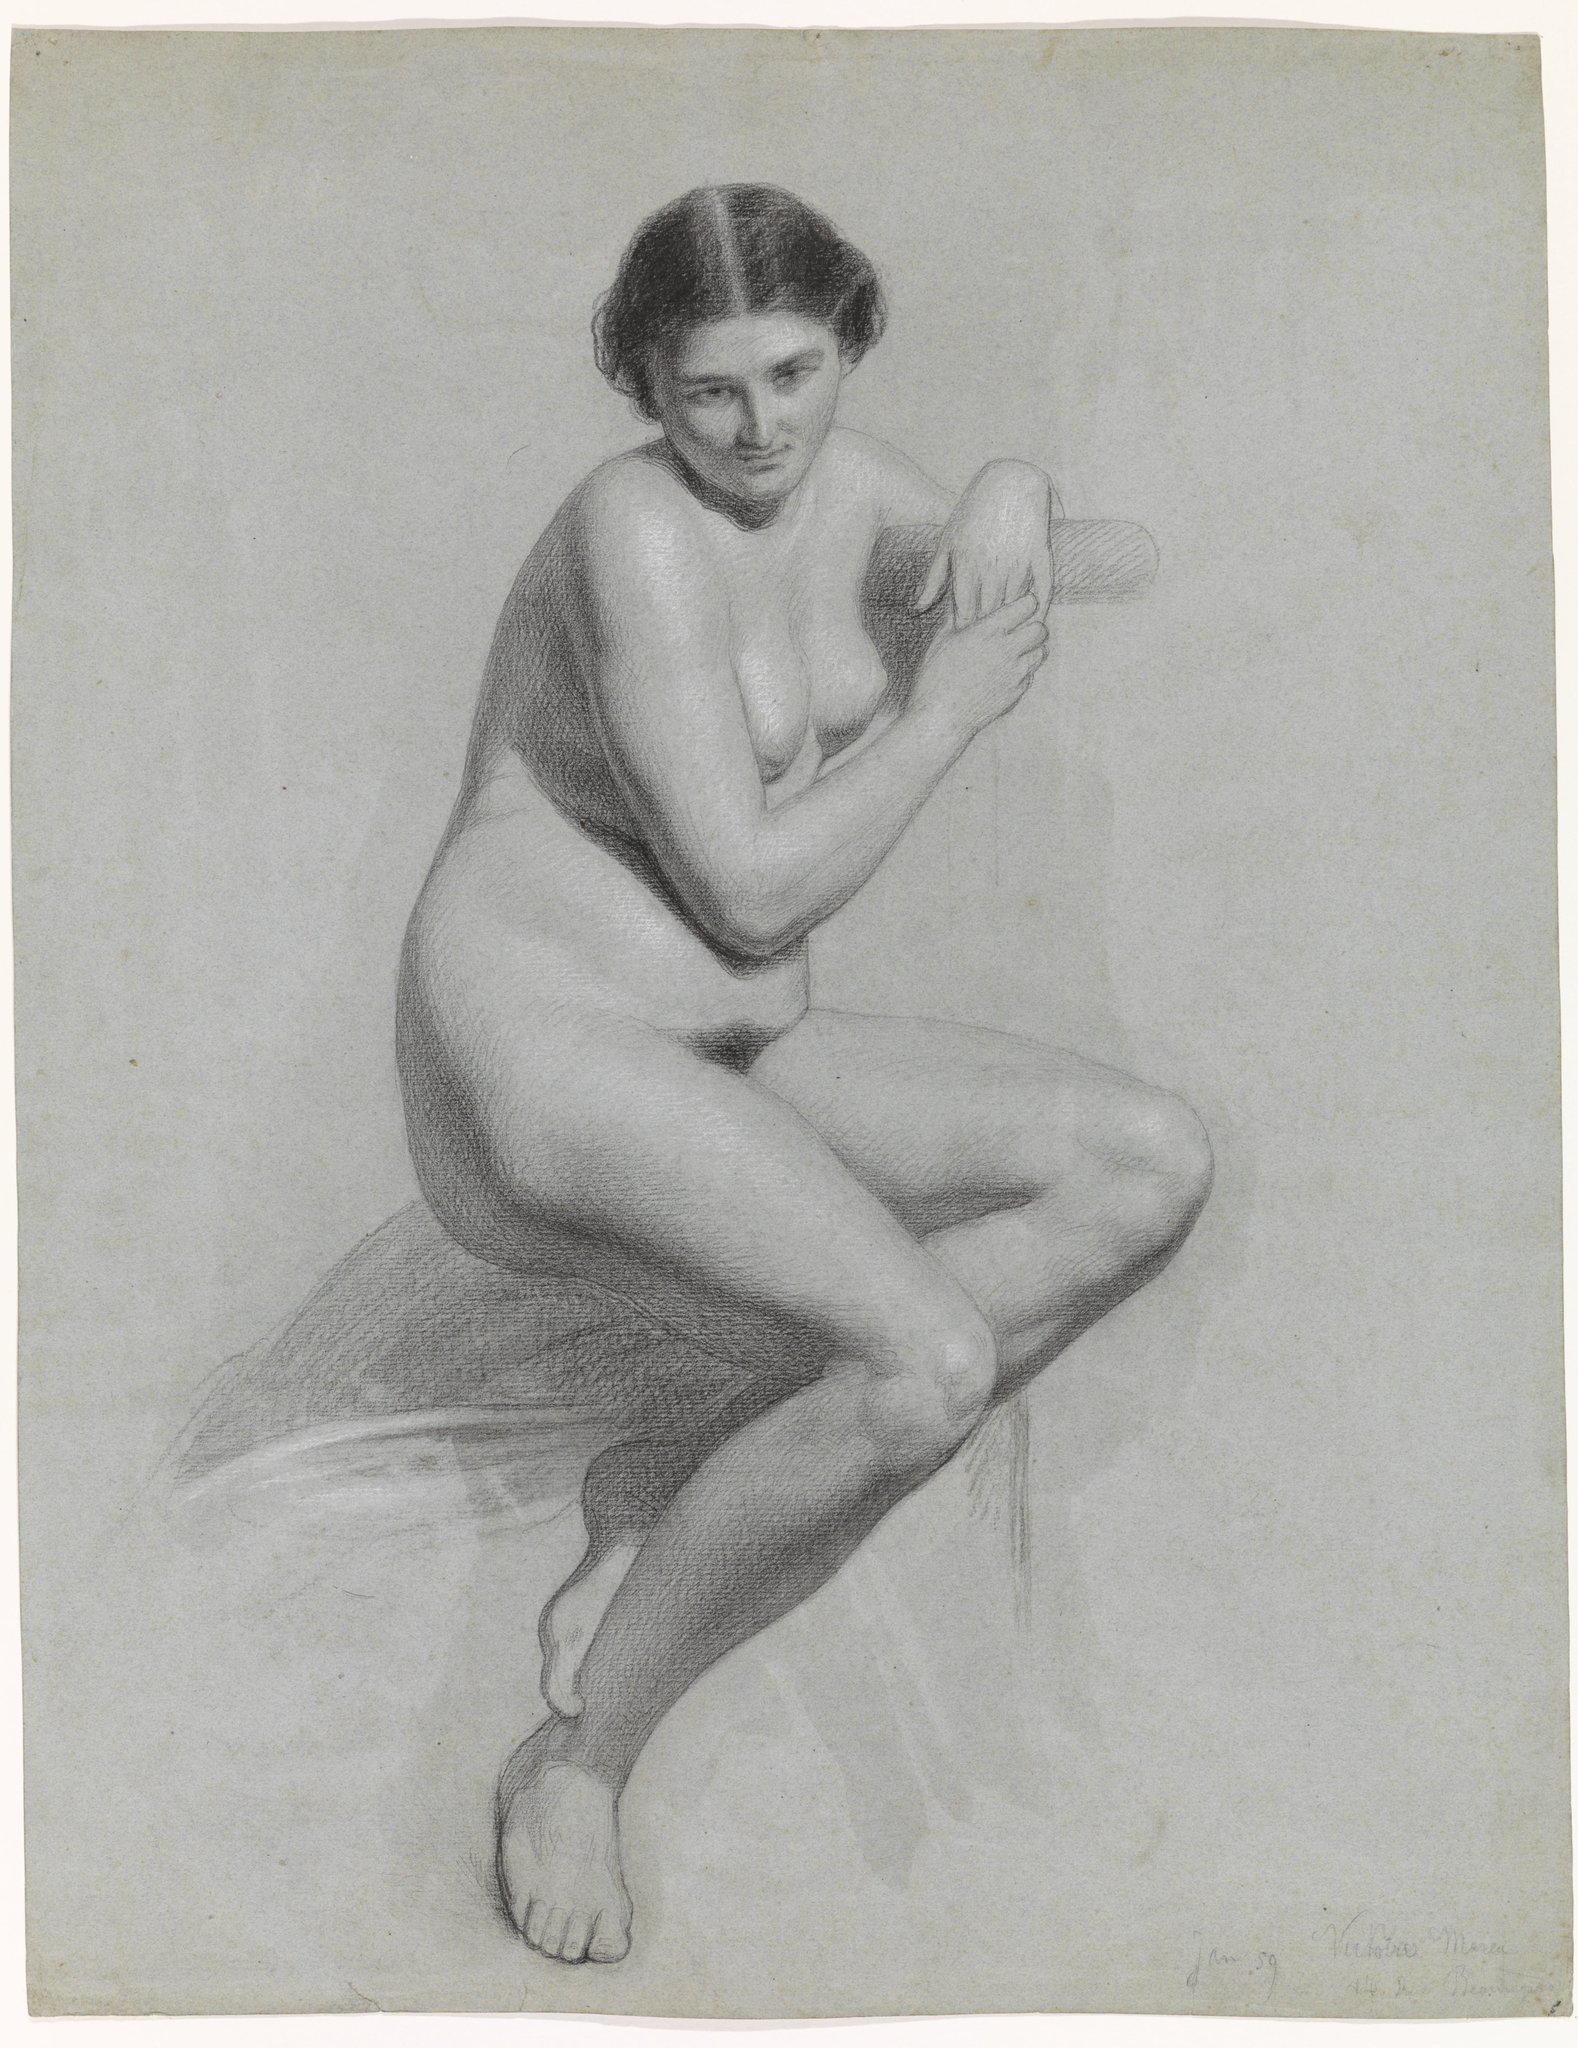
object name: drawing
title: Seated Female Nude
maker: thomas simon cool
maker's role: draughtsman, print maker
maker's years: 1831-1870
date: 1801-1859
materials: chalk, paper